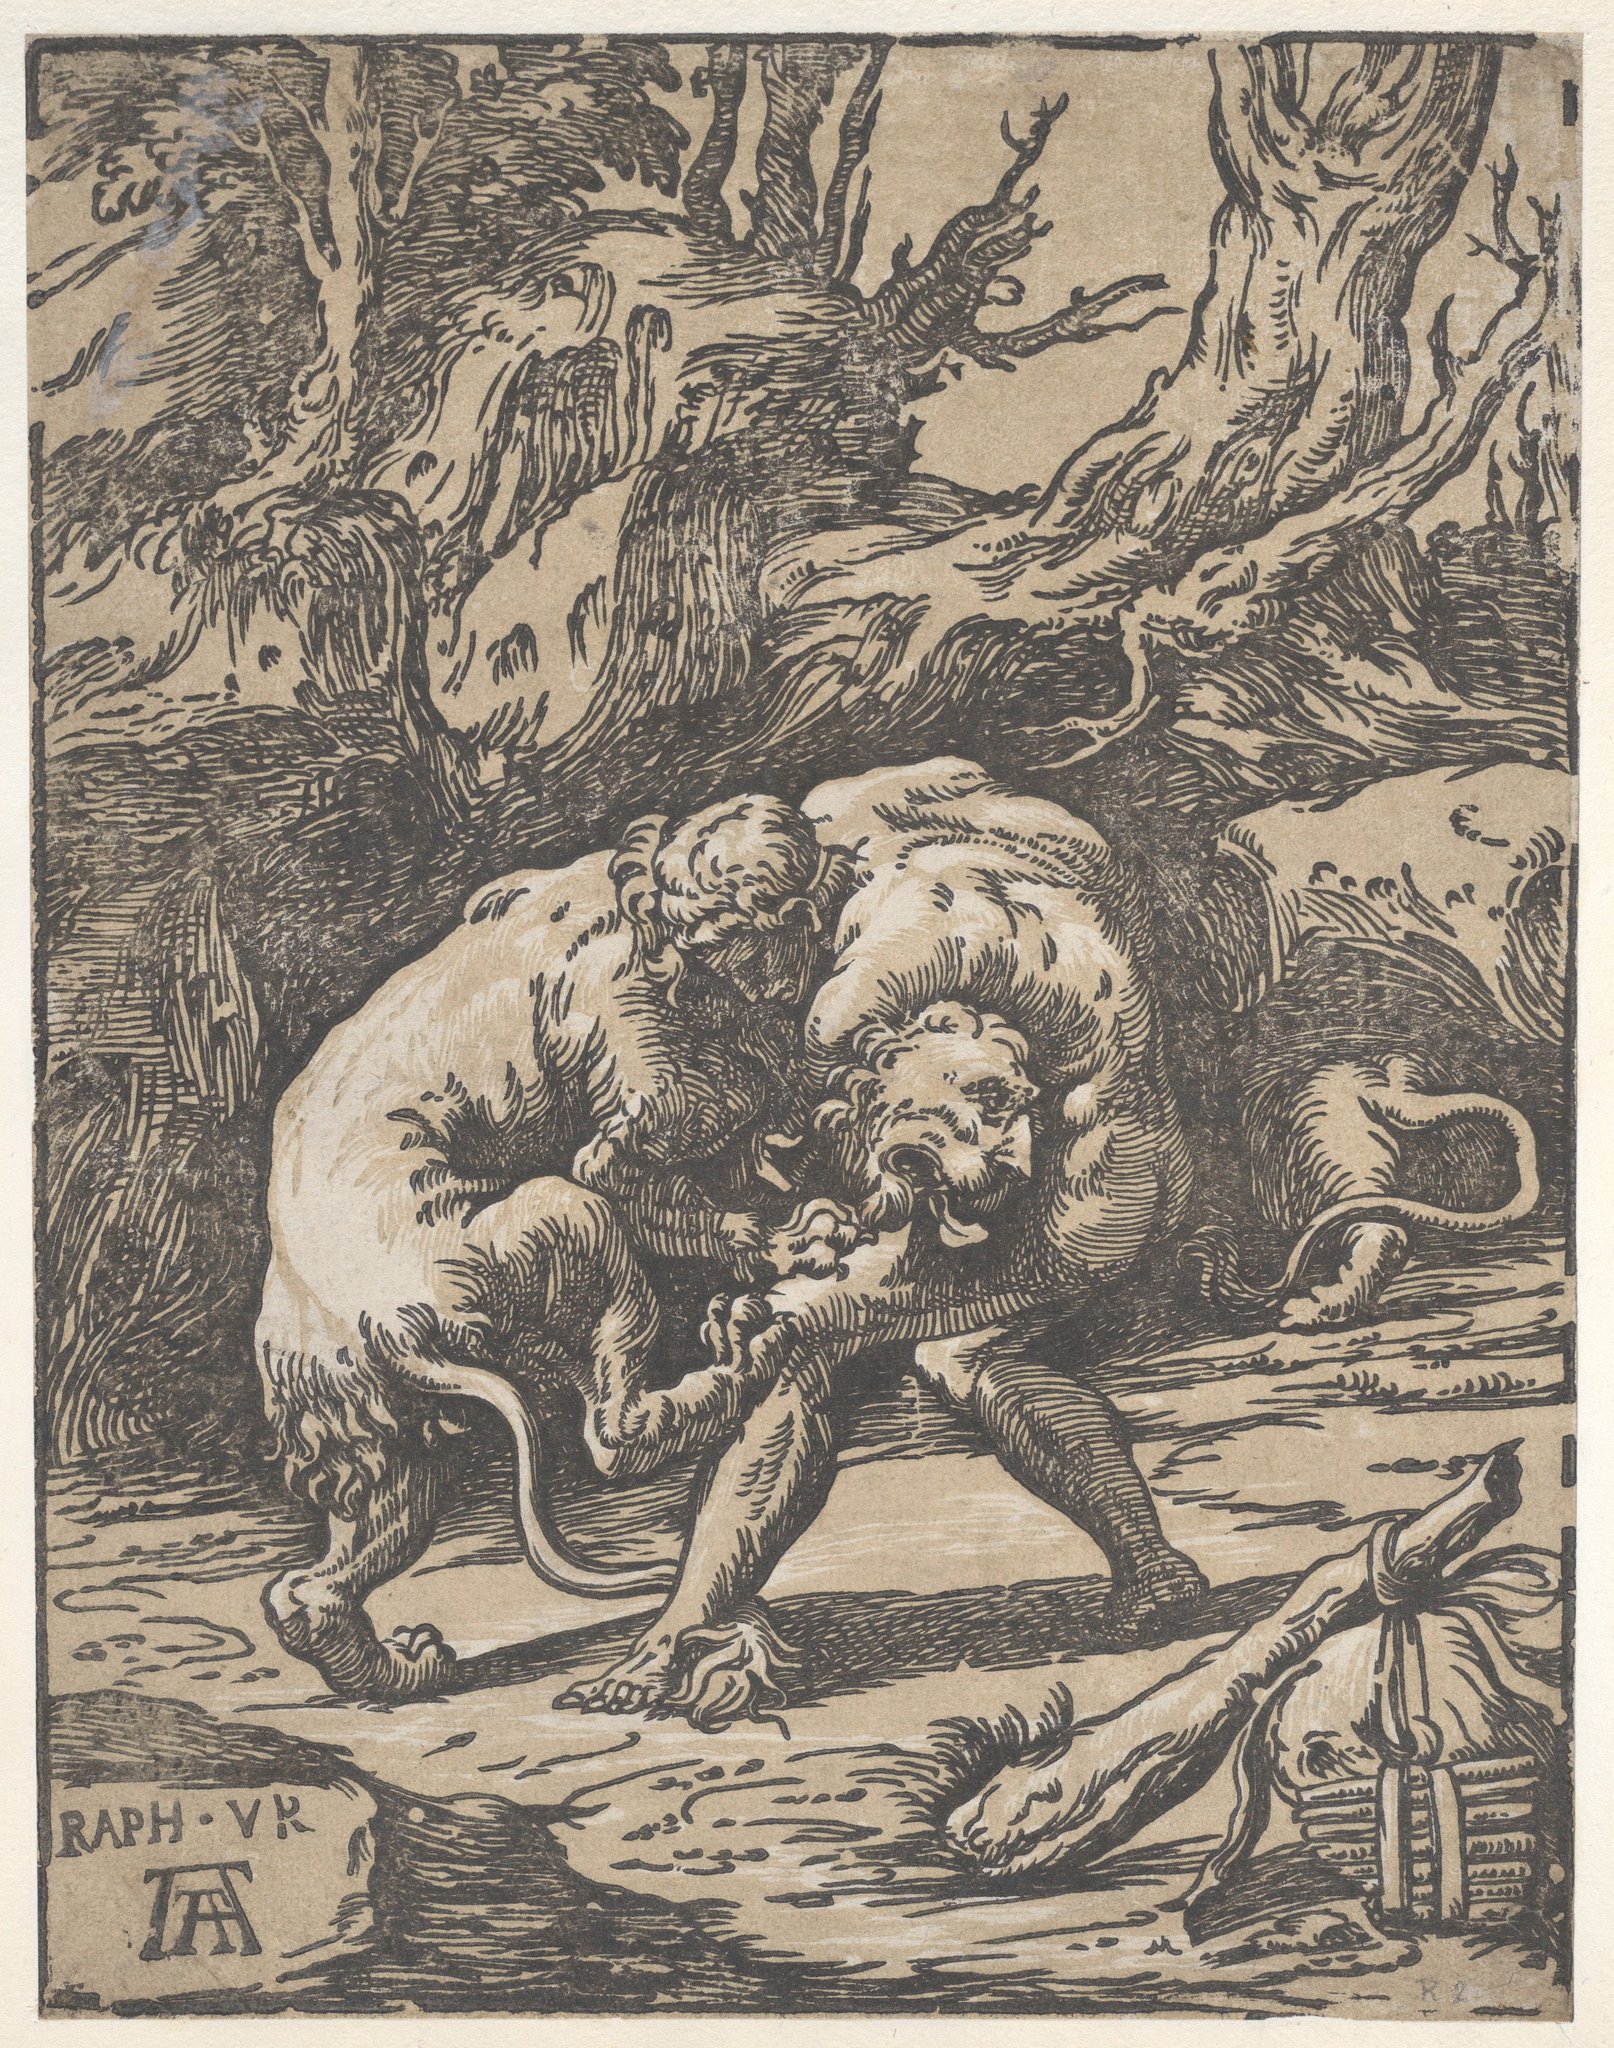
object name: print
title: Hercules and the Nemean Lion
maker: niccolò vicentino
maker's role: artist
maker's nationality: italian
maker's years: 1510-1550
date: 1540-1550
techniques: woodcut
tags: hercules,lions